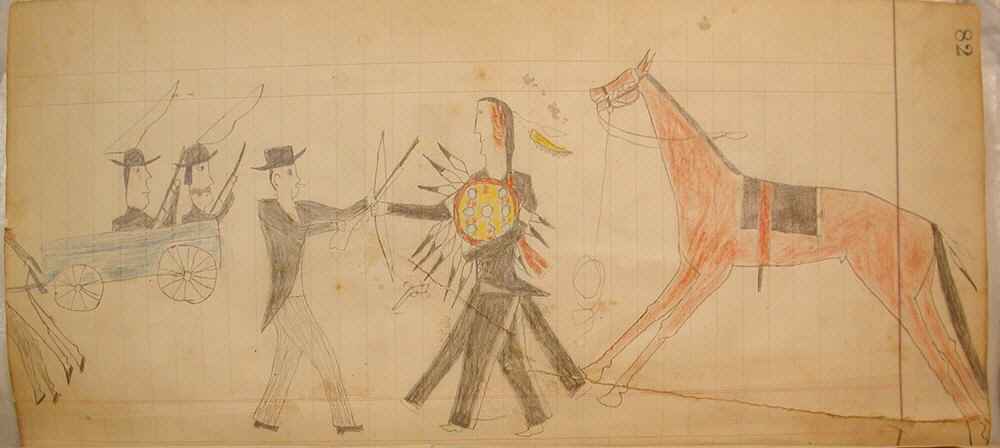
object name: drawing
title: Maffet Ledger: Drawing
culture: cheyenne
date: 1874-1881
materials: crayon, graphite, paper, watercolor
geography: united states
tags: bow and arrow,firearms,men,horses